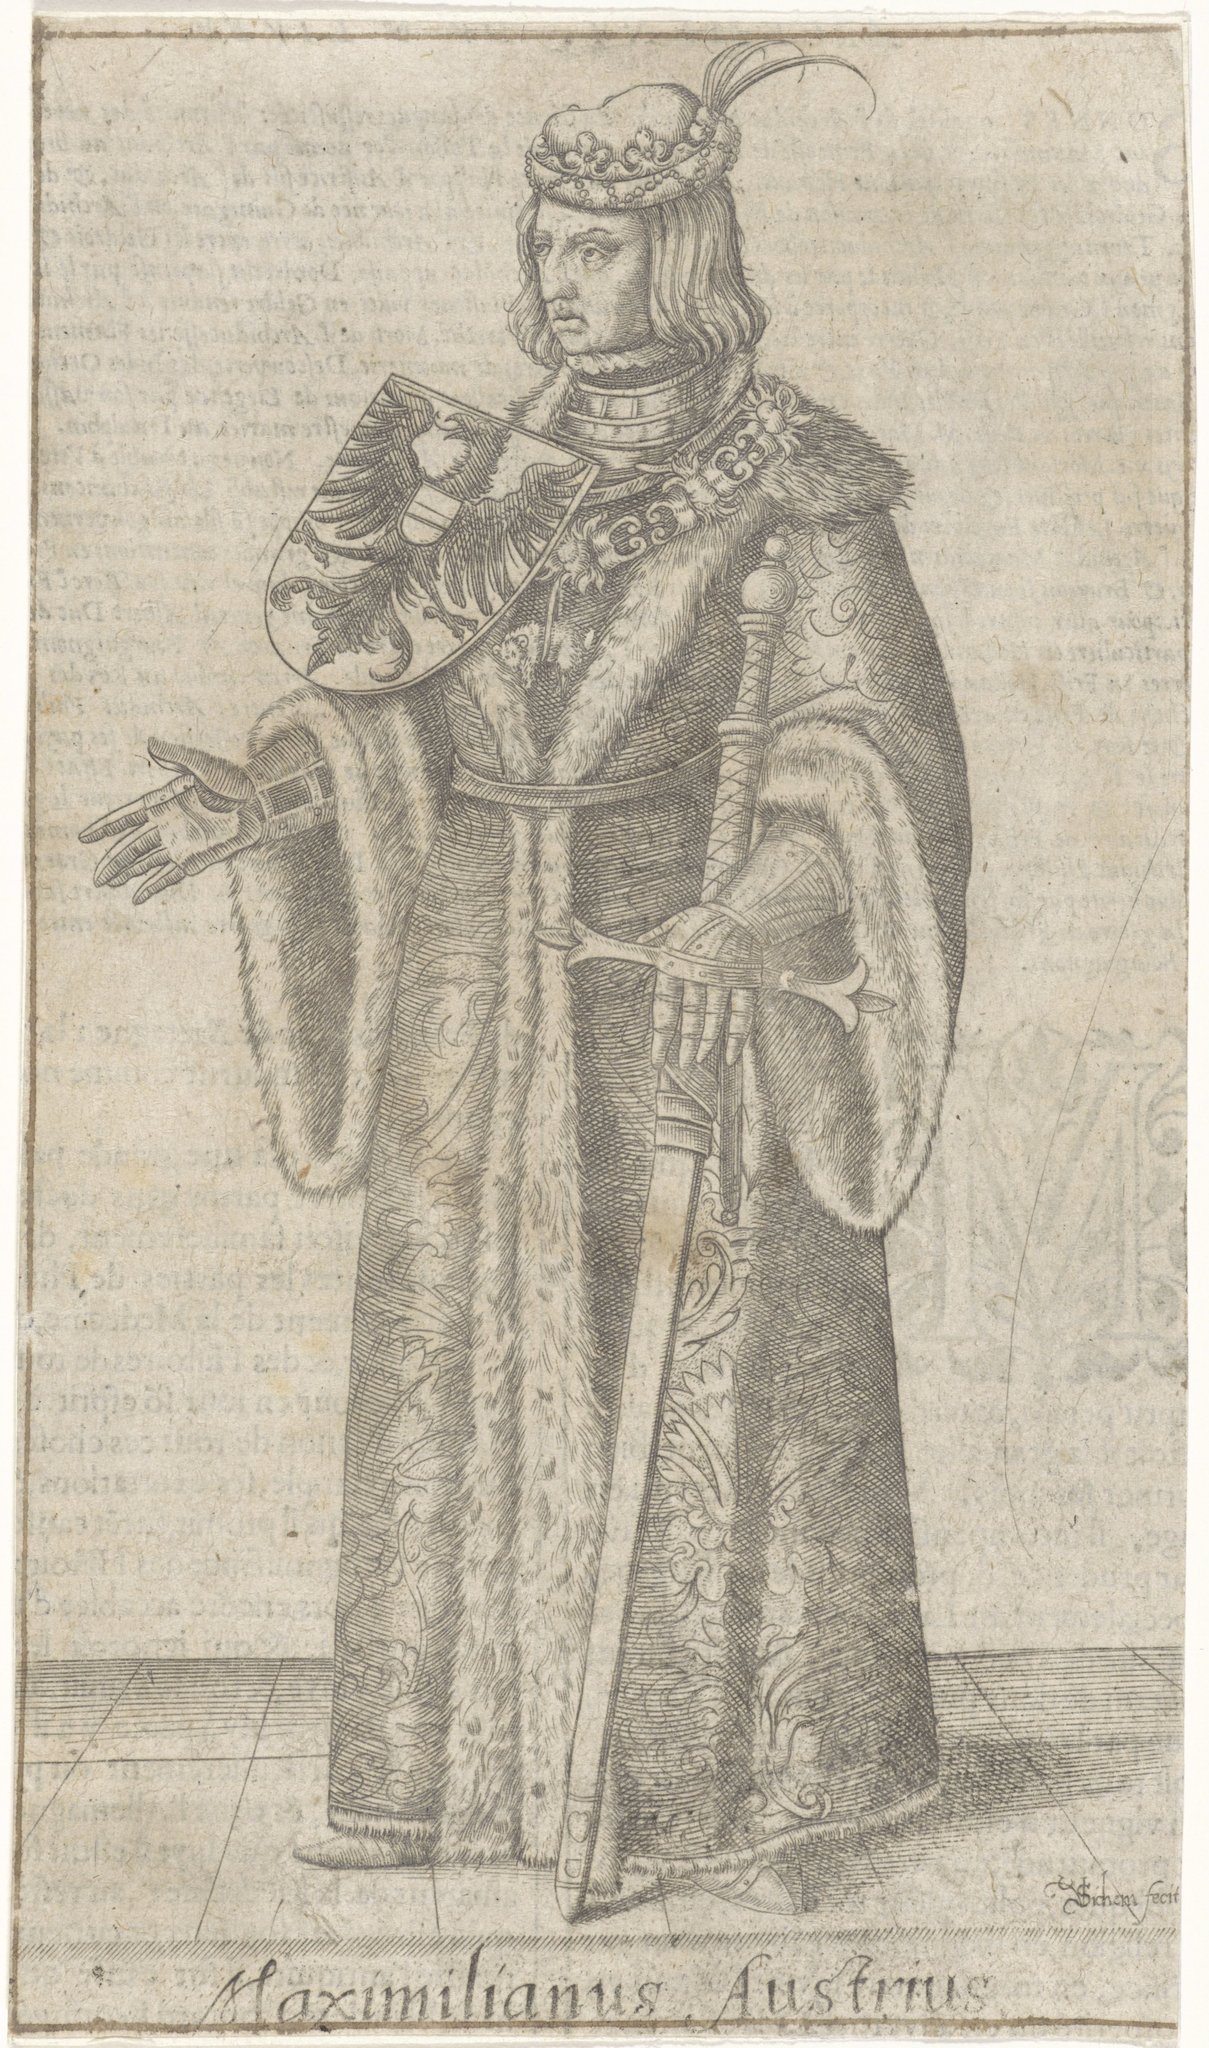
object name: print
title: Maximilianus Austrius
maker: christoffel van sichem (i)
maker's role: print maker, publisher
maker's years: 1546-1624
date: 1601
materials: paper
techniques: engraving, letterpress printing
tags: maximilian i (holy roman emperor)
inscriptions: collector's mark: Lugt 2228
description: Prent komt voor in: Jean François Le Petit. La grande chroniqve ancienne et moderne, de Hollande, Zelande, VVestfrise, Vtrecht, Frise, Overyssel & Groeningen. 2 vols. Dordrecht: J. Canin en G. Guillemot, 1601.